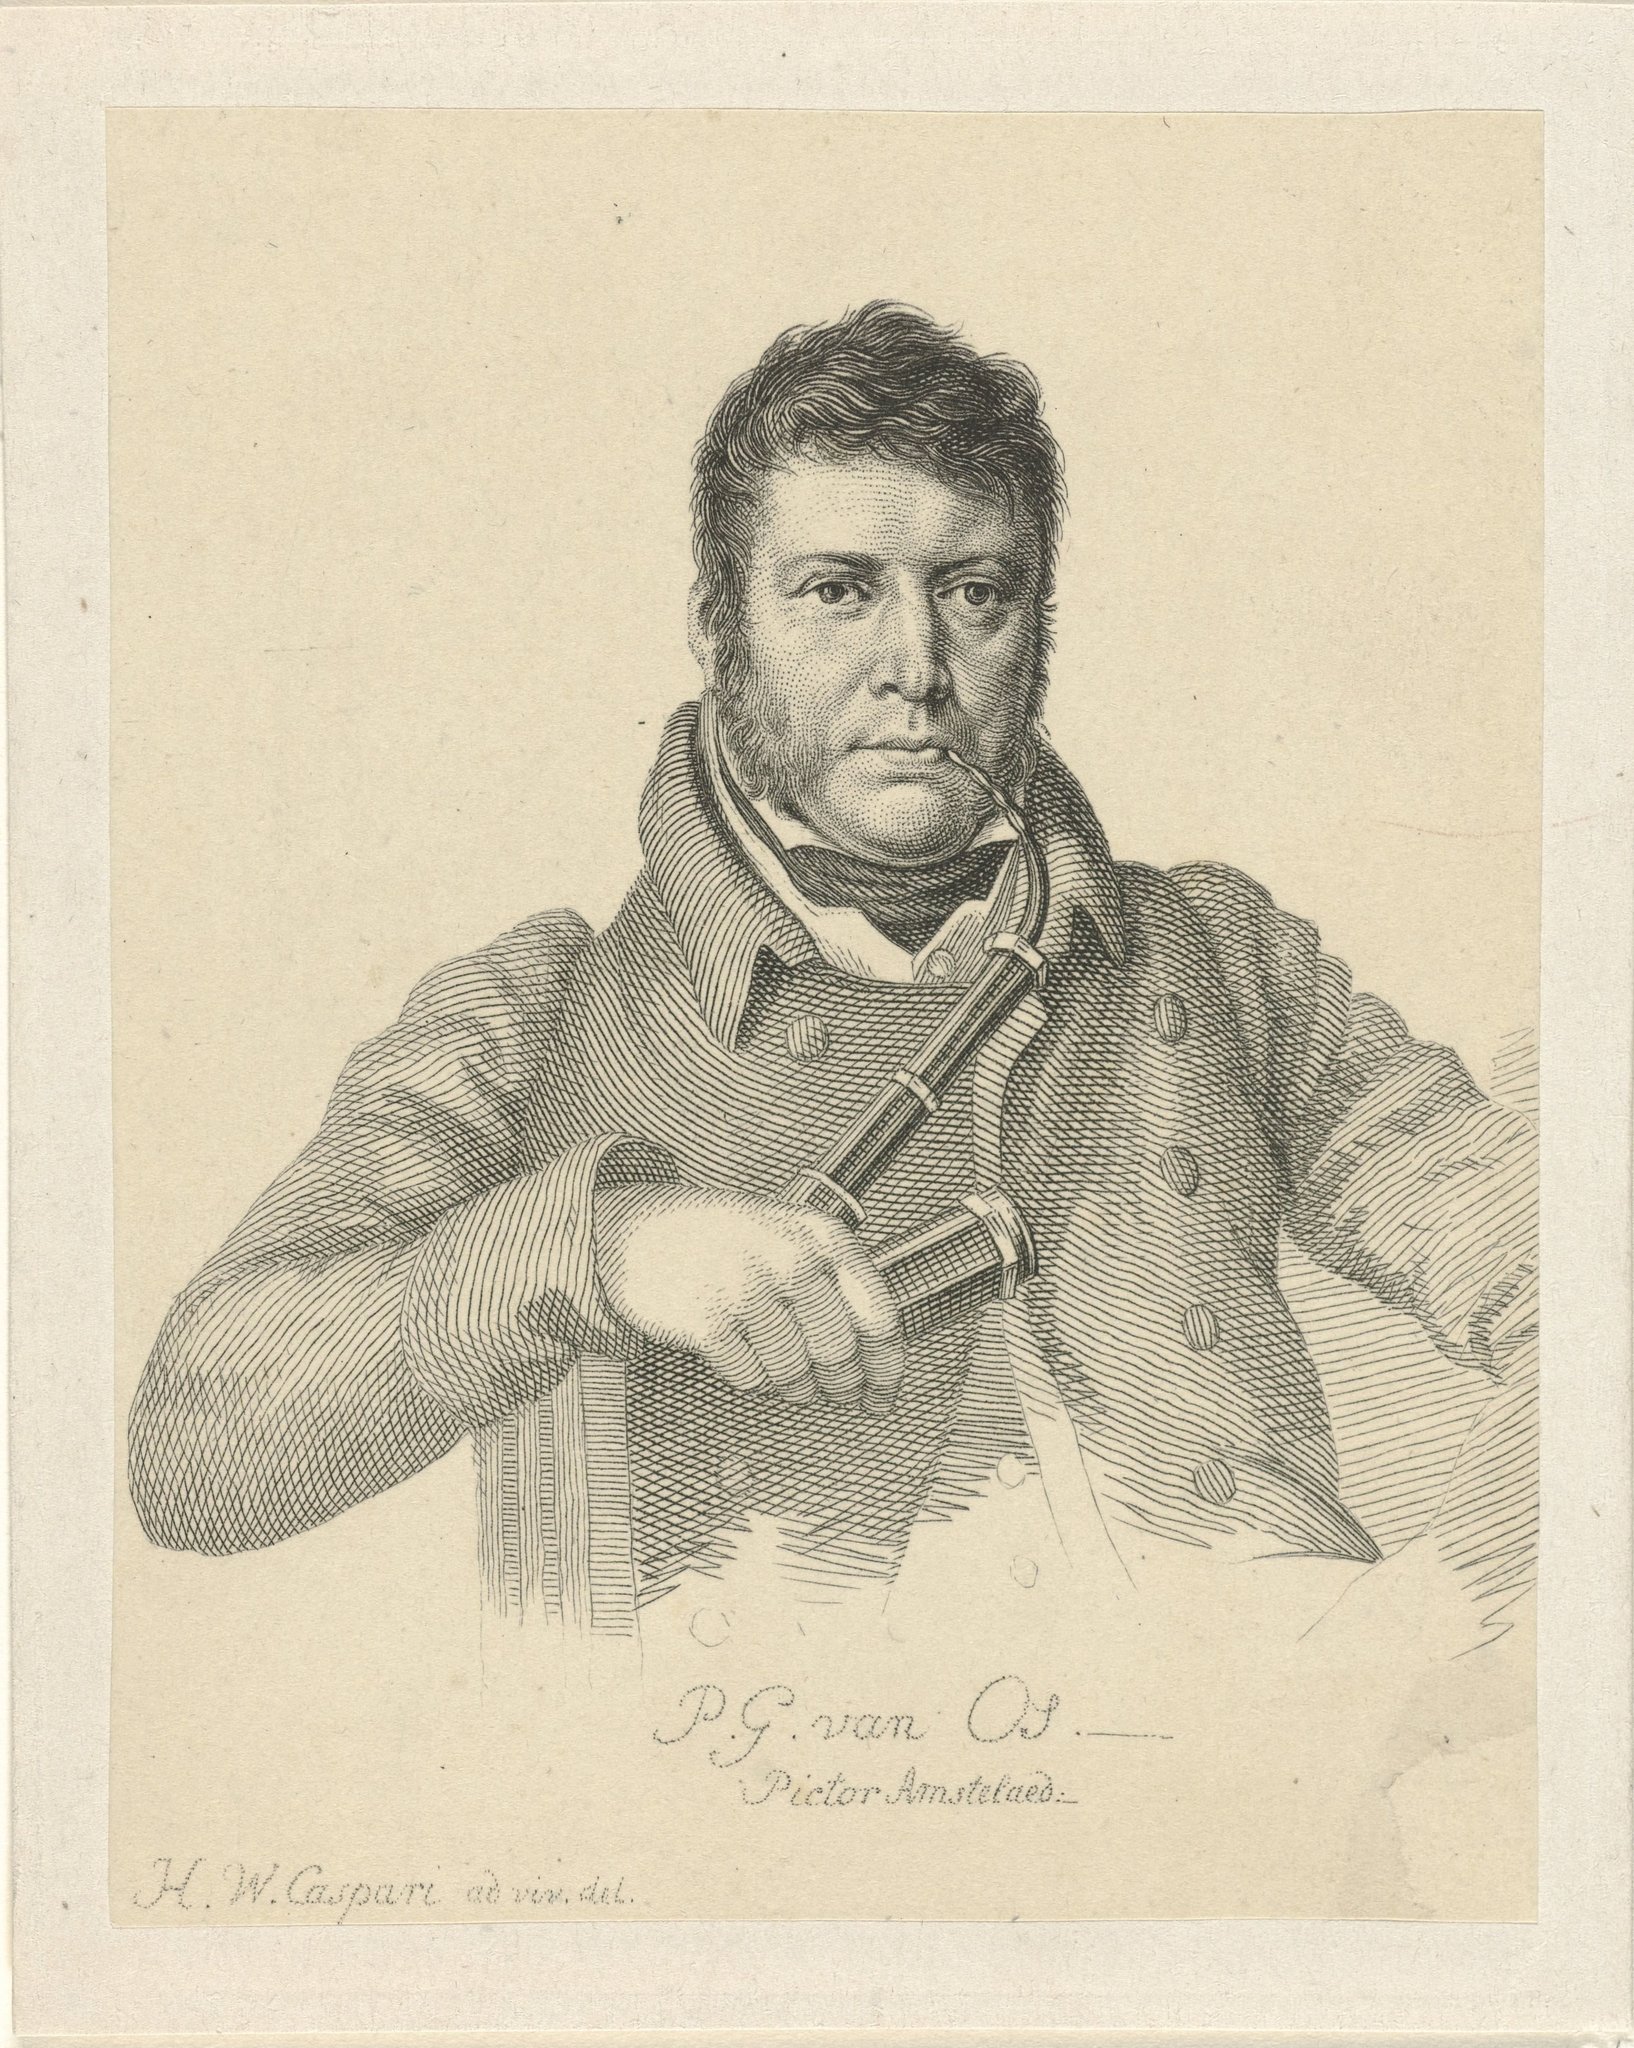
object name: print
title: Studie-prentwerk / Etudes gravées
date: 1804-1816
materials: paper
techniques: etching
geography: amsterdam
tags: painter, print maker, draughtsman, pieter gerardus van os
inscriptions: collector's mark: Lugt 2228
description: Serie voor het eerst uitgegeven door Jacob Ernst Marcus onder de titel Studiebeelden en Fragmenten. Amsterdam: ca.1816. Later heruitgegeven als: Studie-prentwerk/ Etudes gravées.